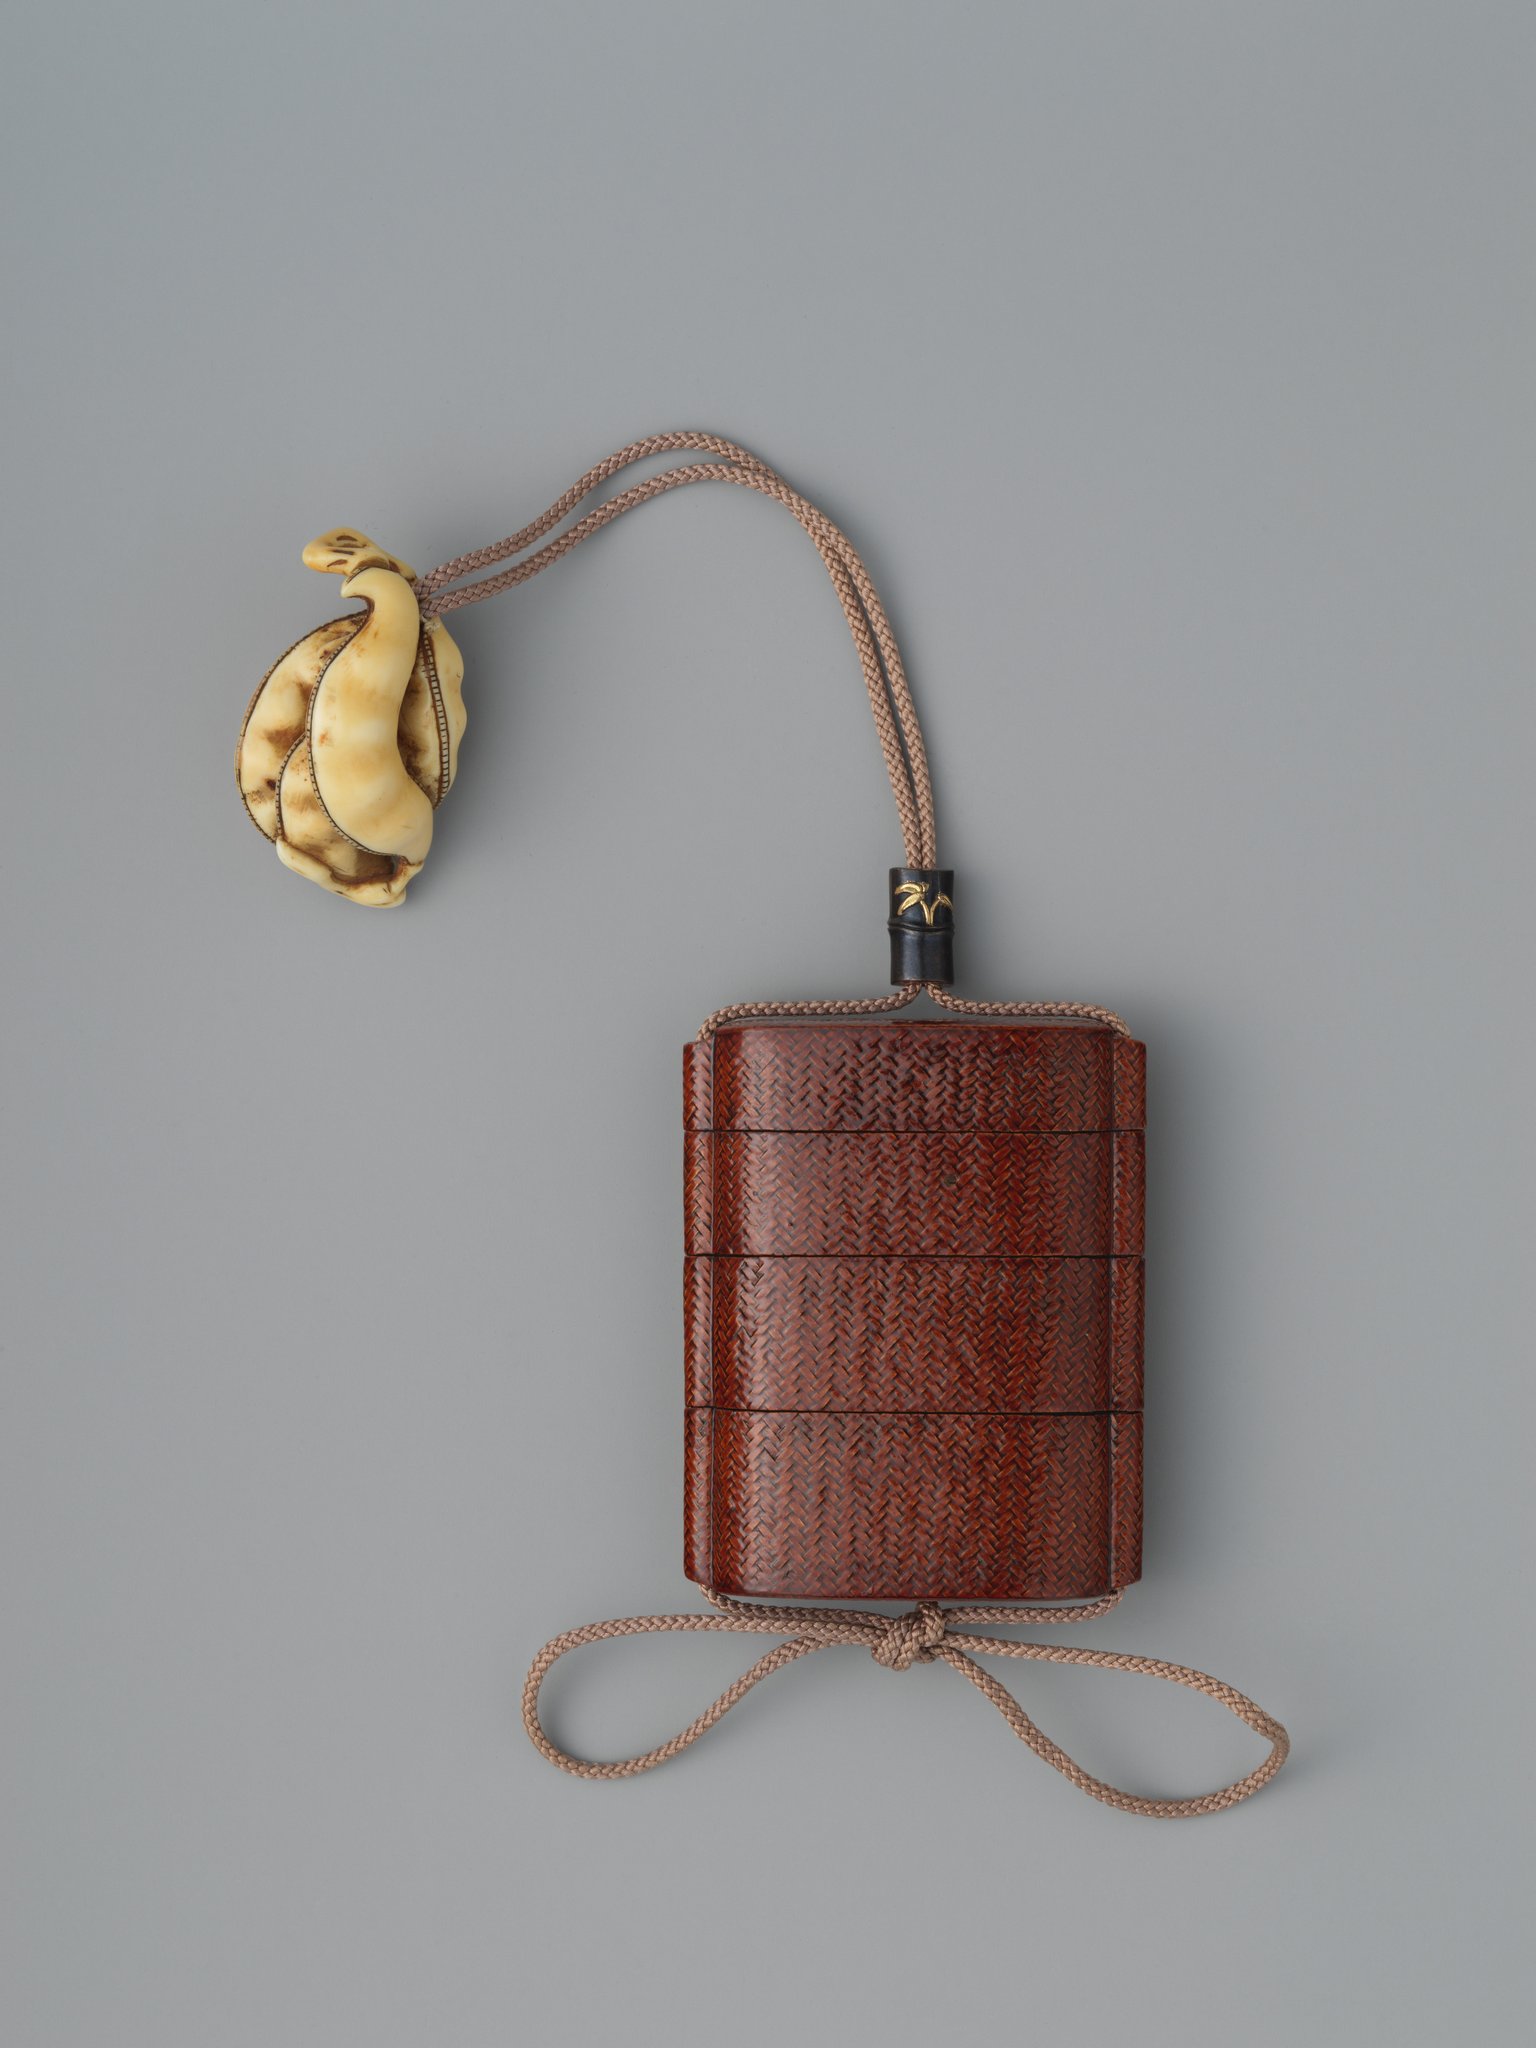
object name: inrō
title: Basketry Inrō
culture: japanese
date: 1834-1866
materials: bamboo, bronze, gold, ivory, lacquer, rattan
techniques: inlay, urushi